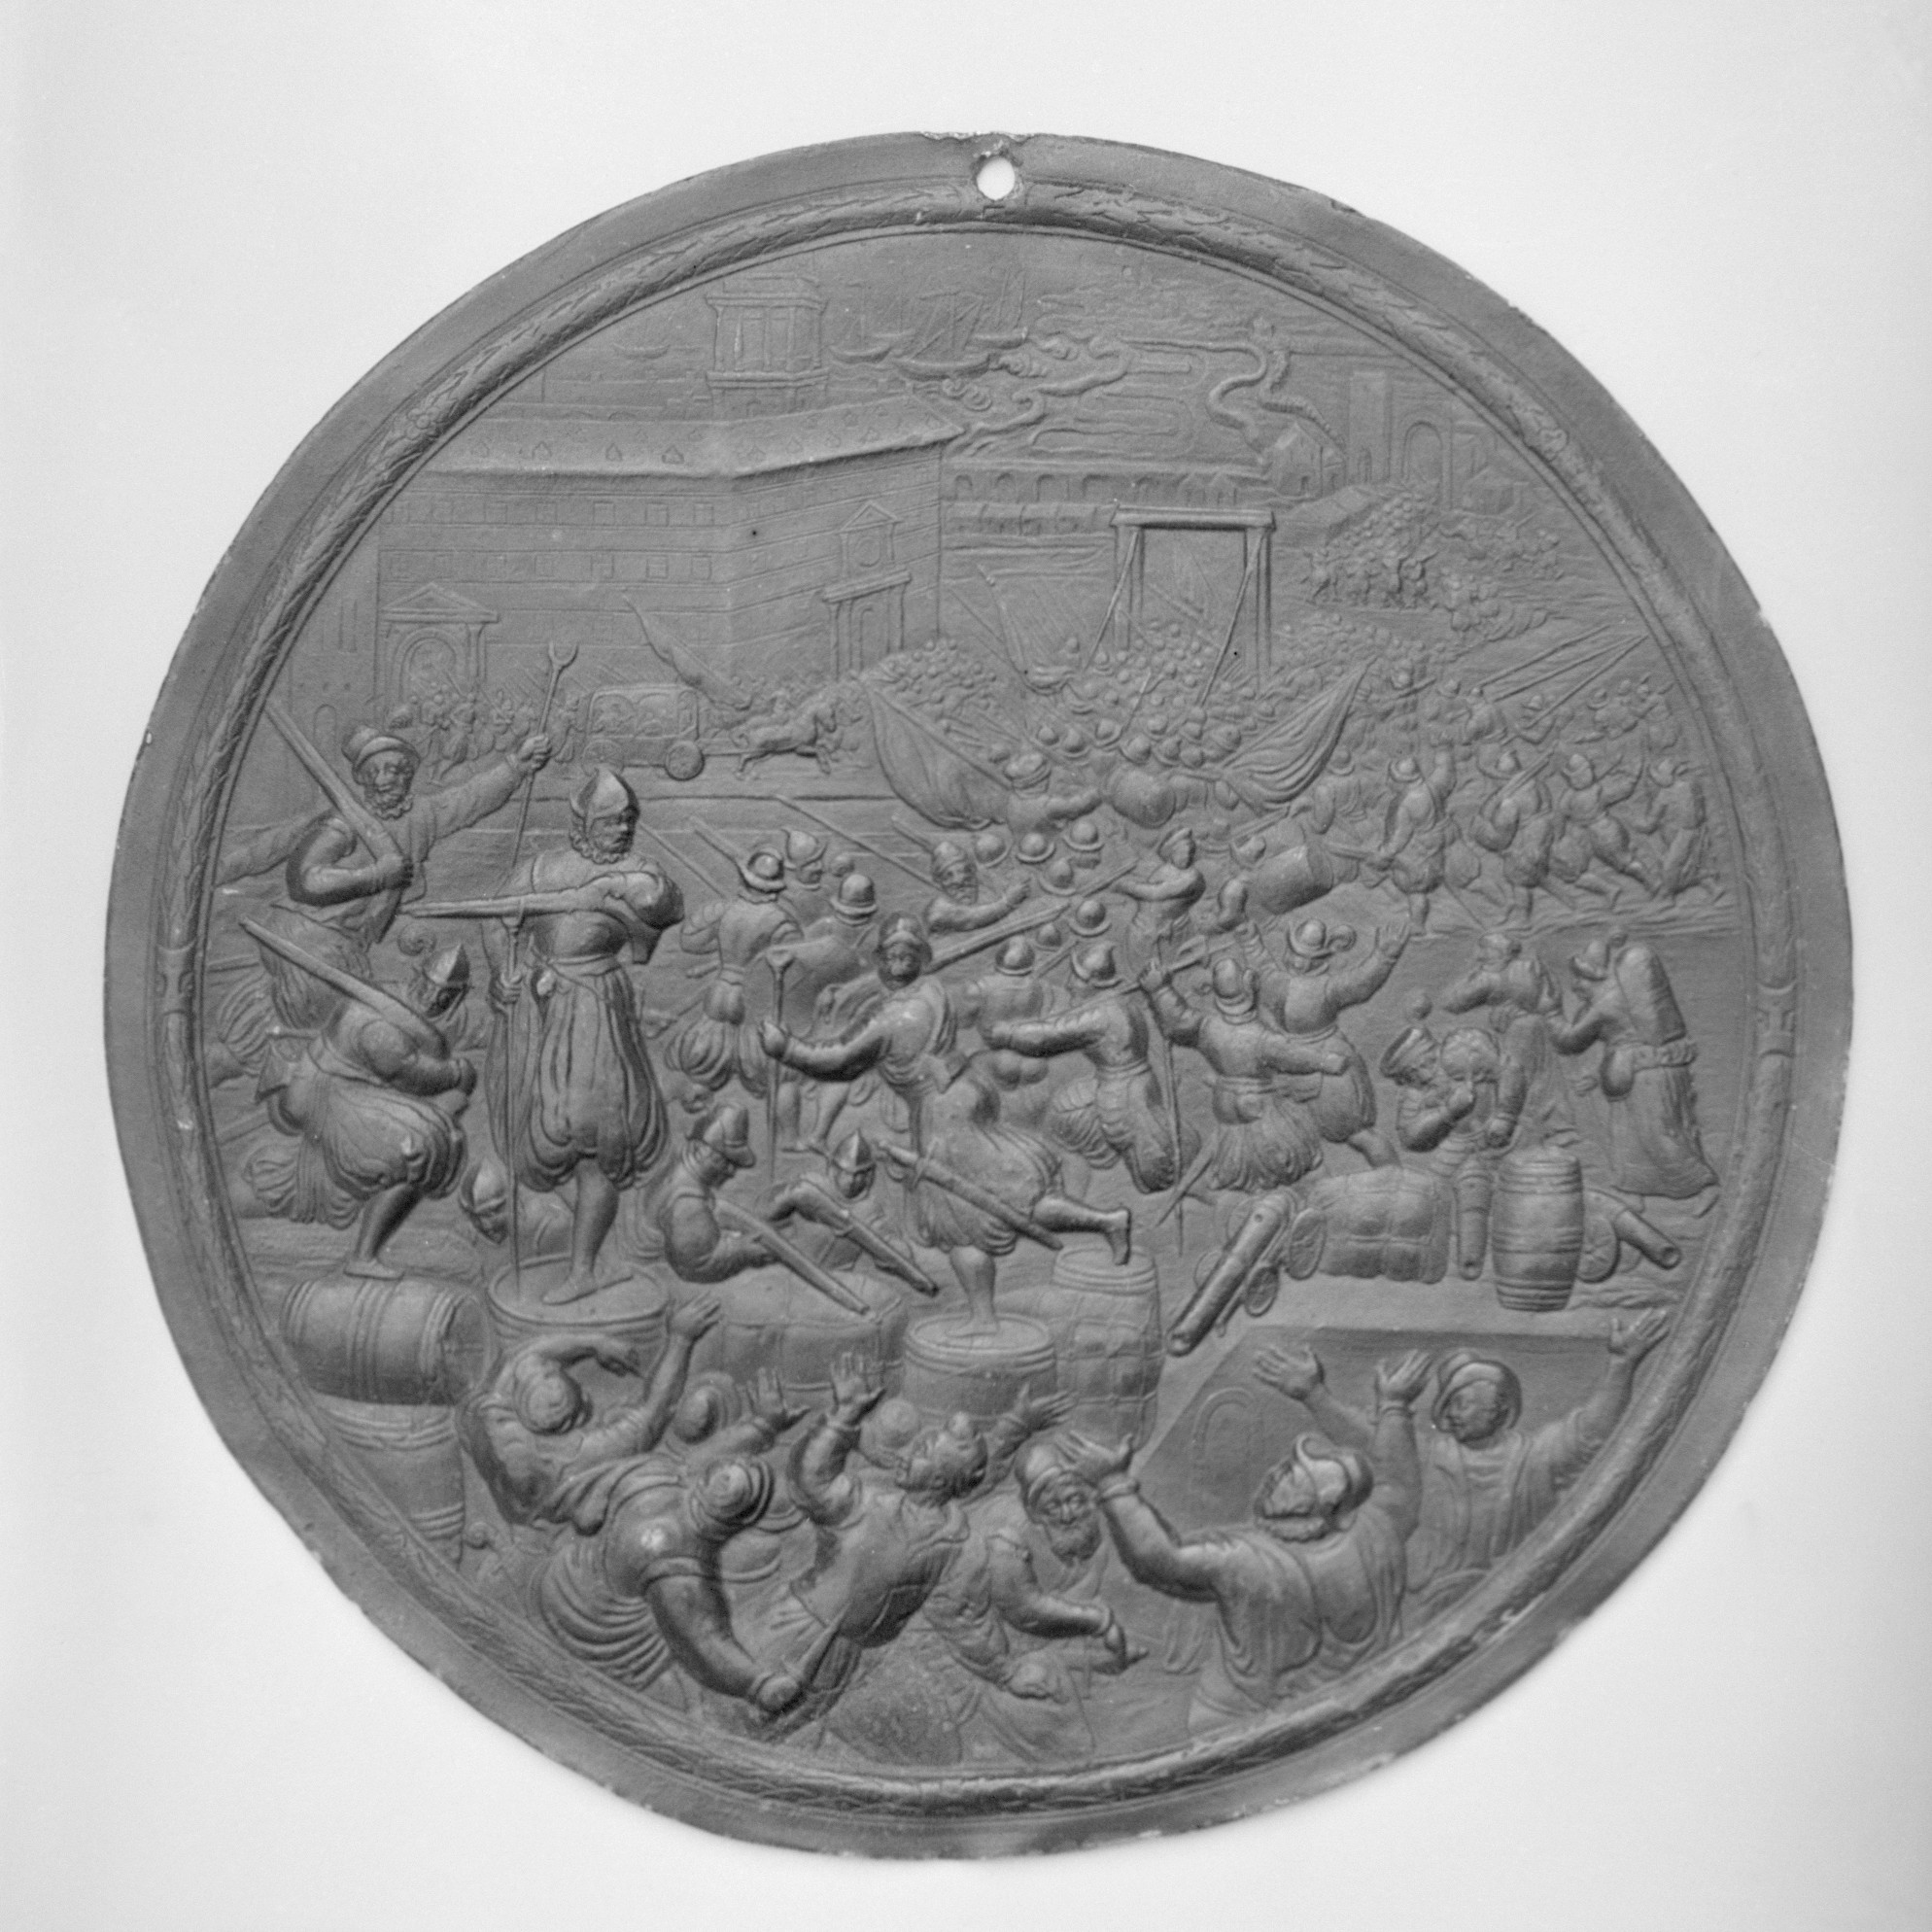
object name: plaquette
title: The Routing of Focker and the German Troops from Antwerp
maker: maerten de vos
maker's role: designer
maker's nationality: netherlandish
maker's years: 1532-1603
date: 1580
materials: pewter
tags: battles,soldiers